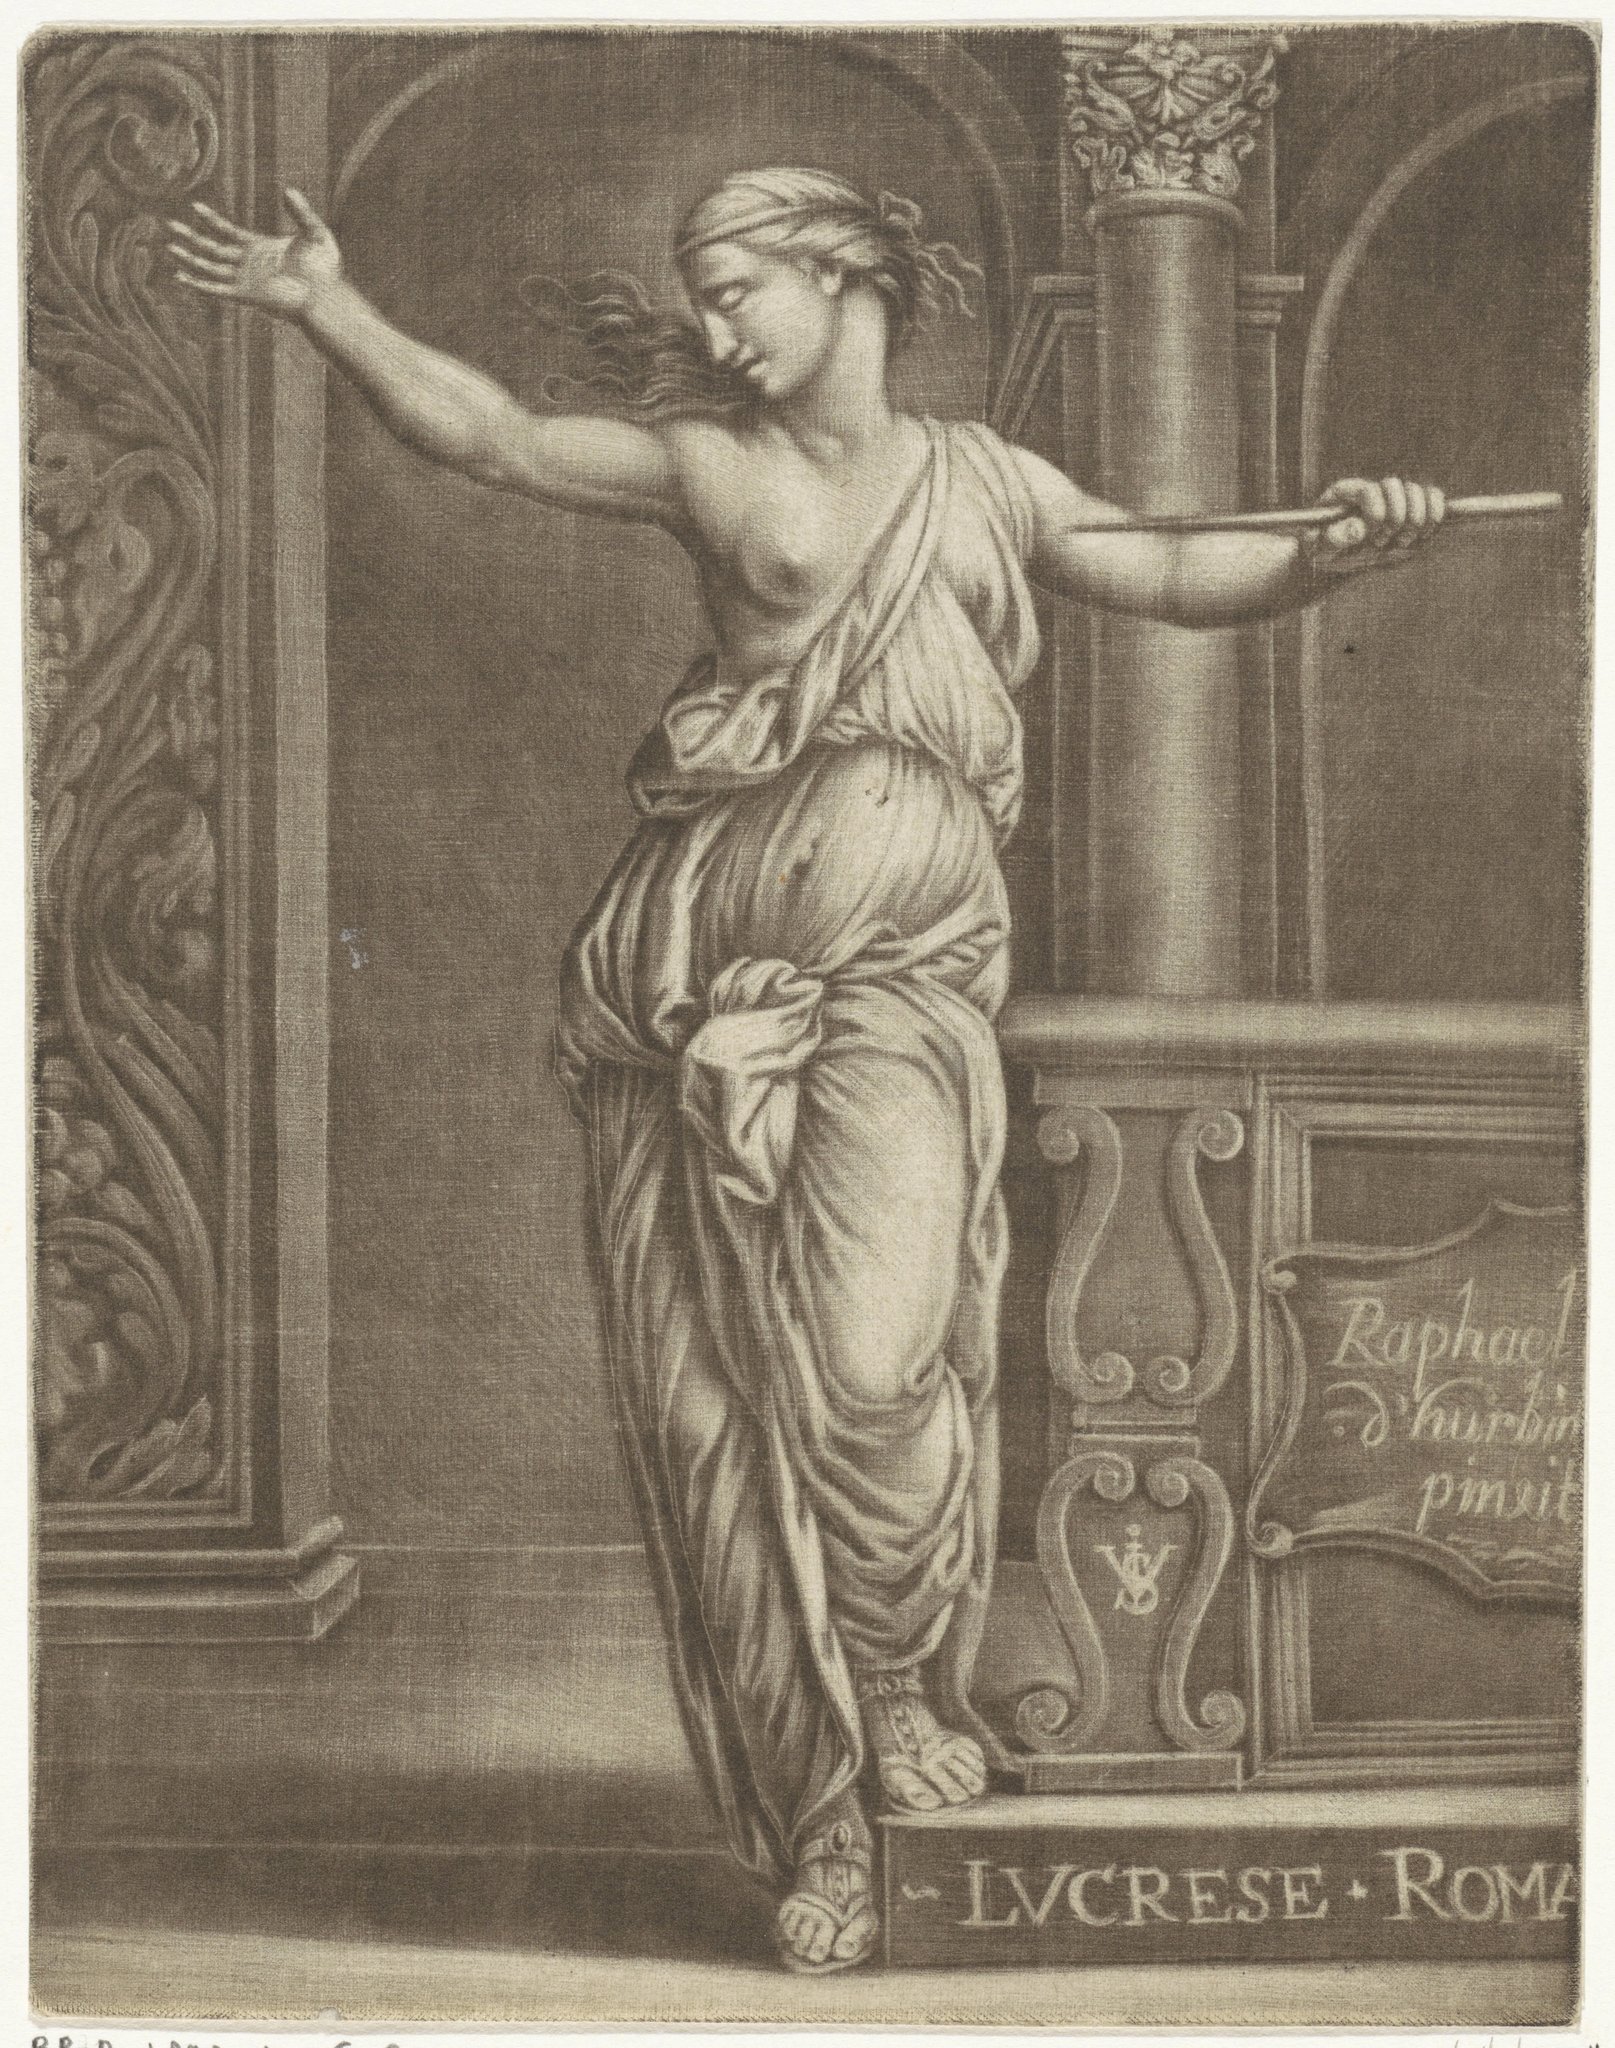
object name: print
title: Zelfmoord van Lucretia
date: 1655-1700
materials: paper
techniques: mezzotint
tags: death of lucretia: she commits suicide by stabbing herself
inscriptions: collector's mark: Lugt 2228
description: Lucretia staat op het punt om een dolk in haar borst te steken.